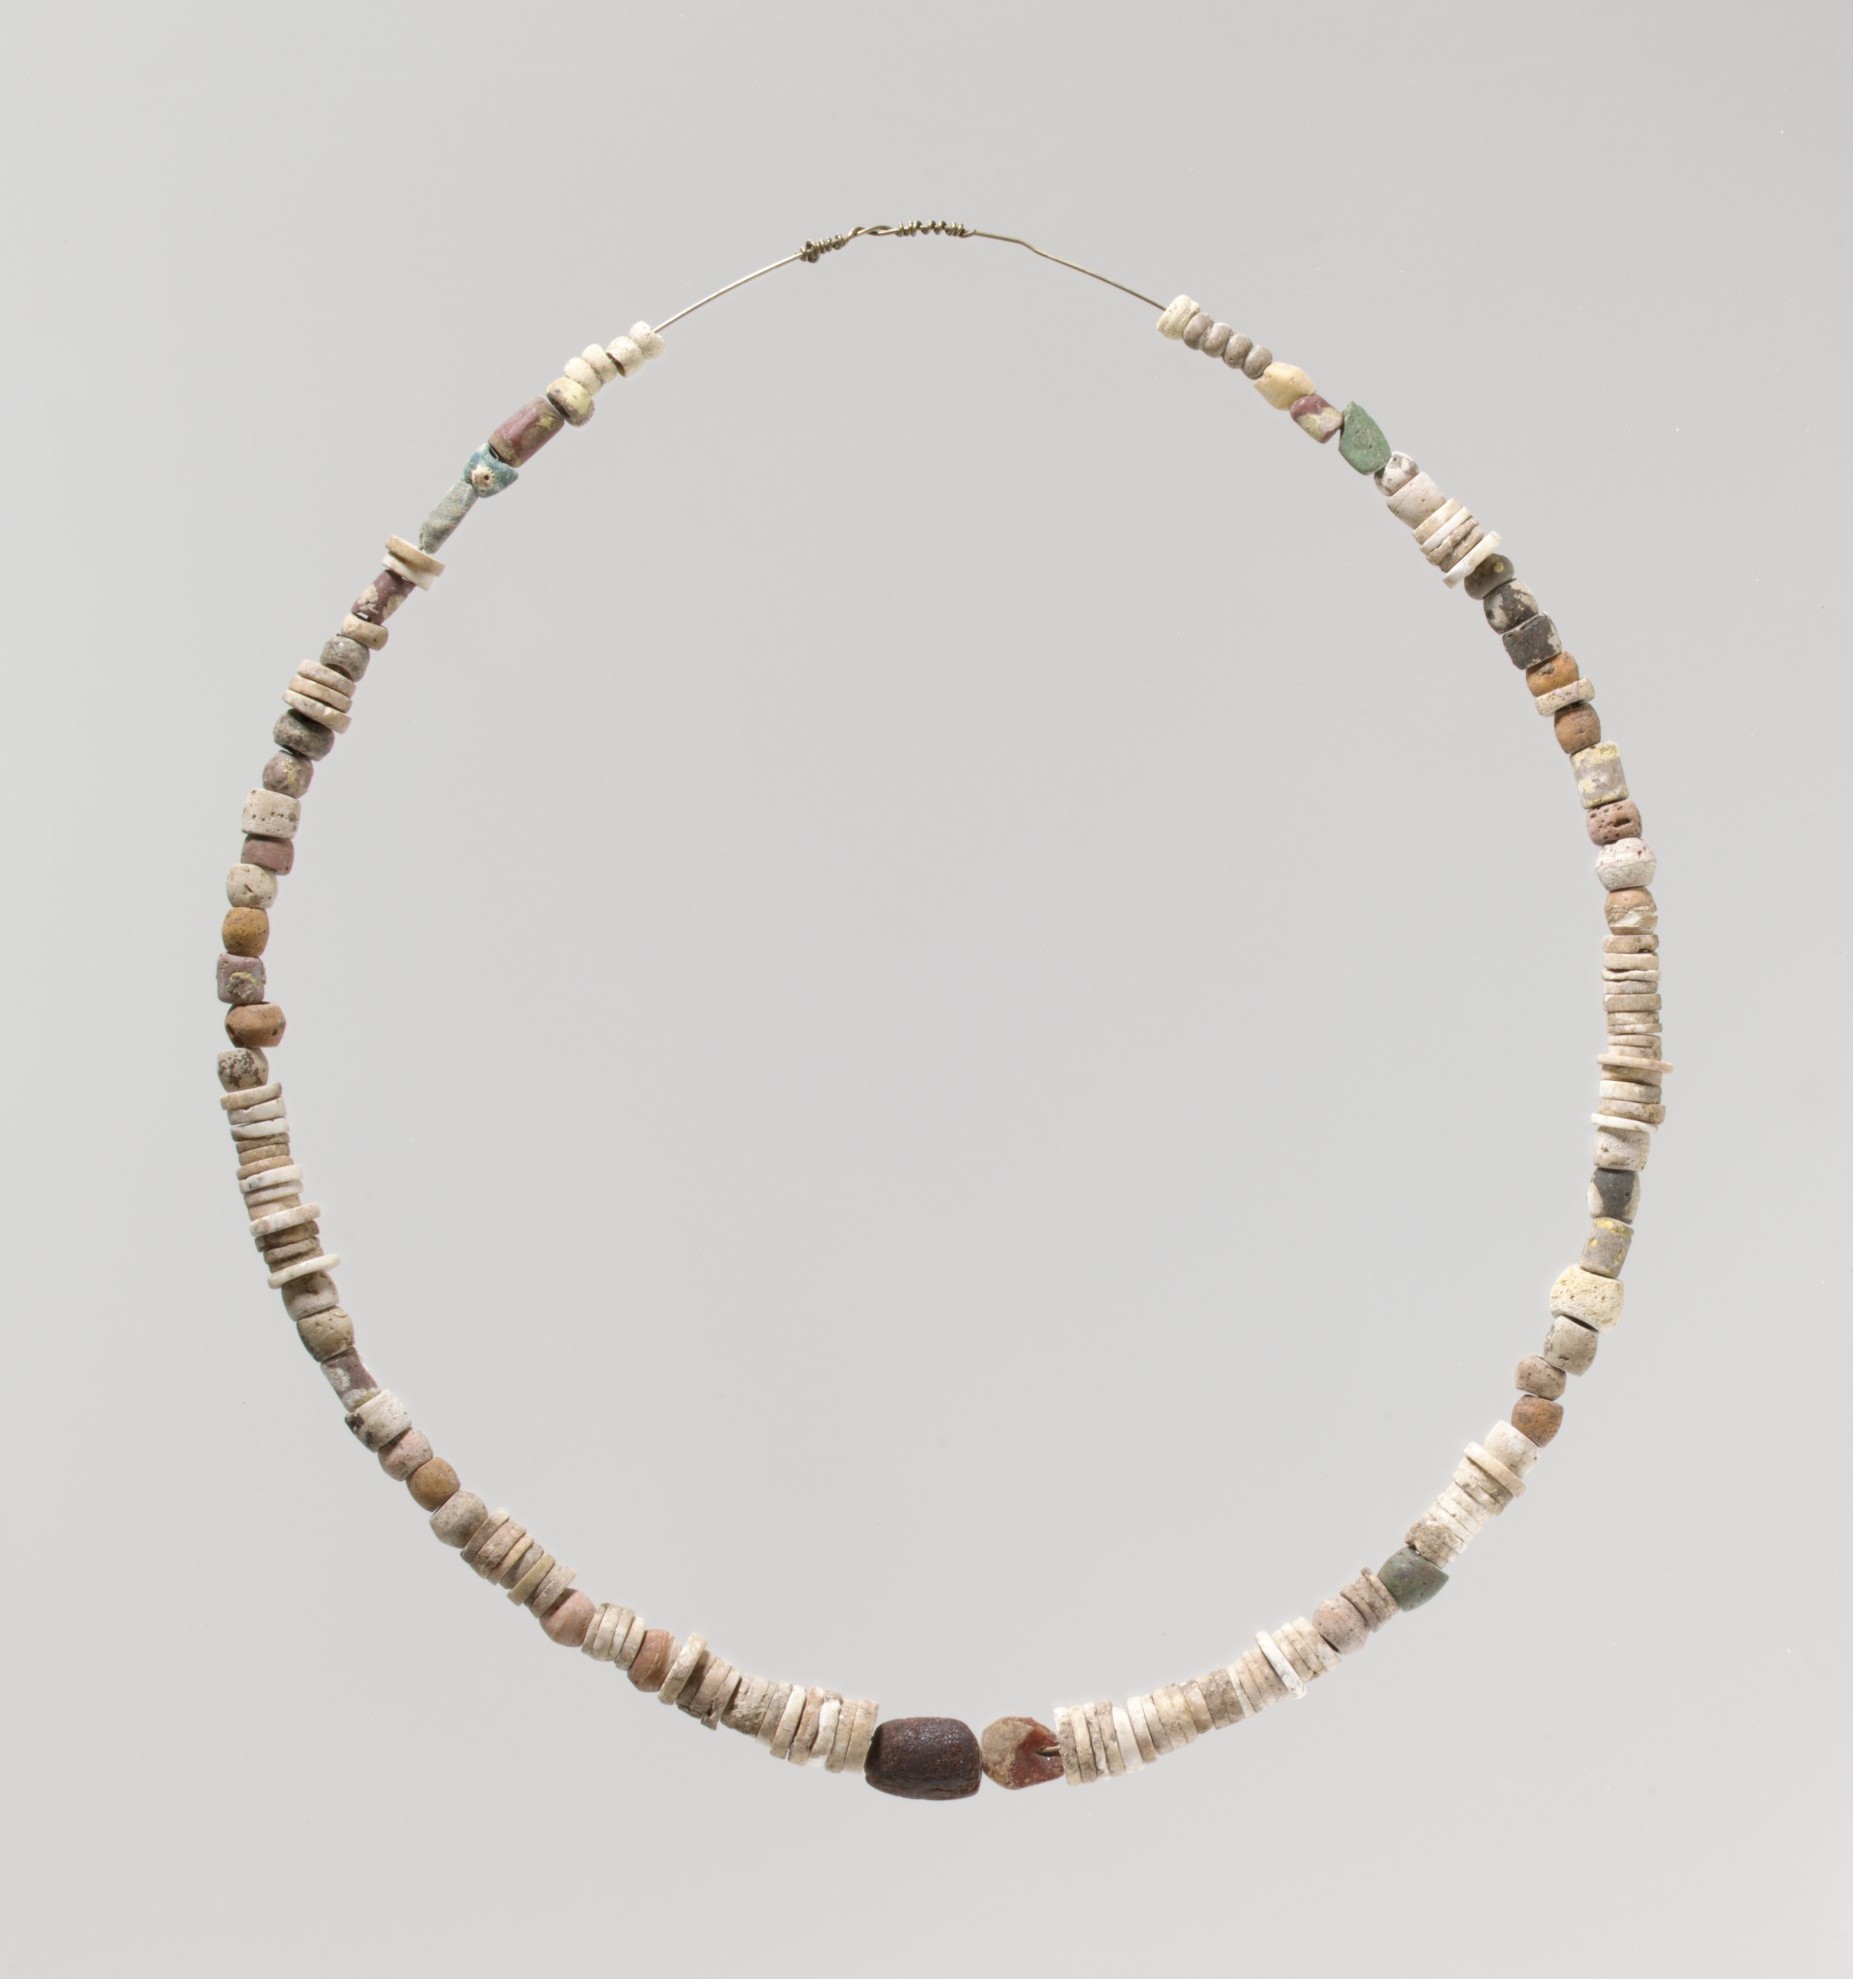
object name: necklace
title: Beads from a Necklace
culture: frankish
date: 501-700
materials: amber, glass, shell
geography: western germany